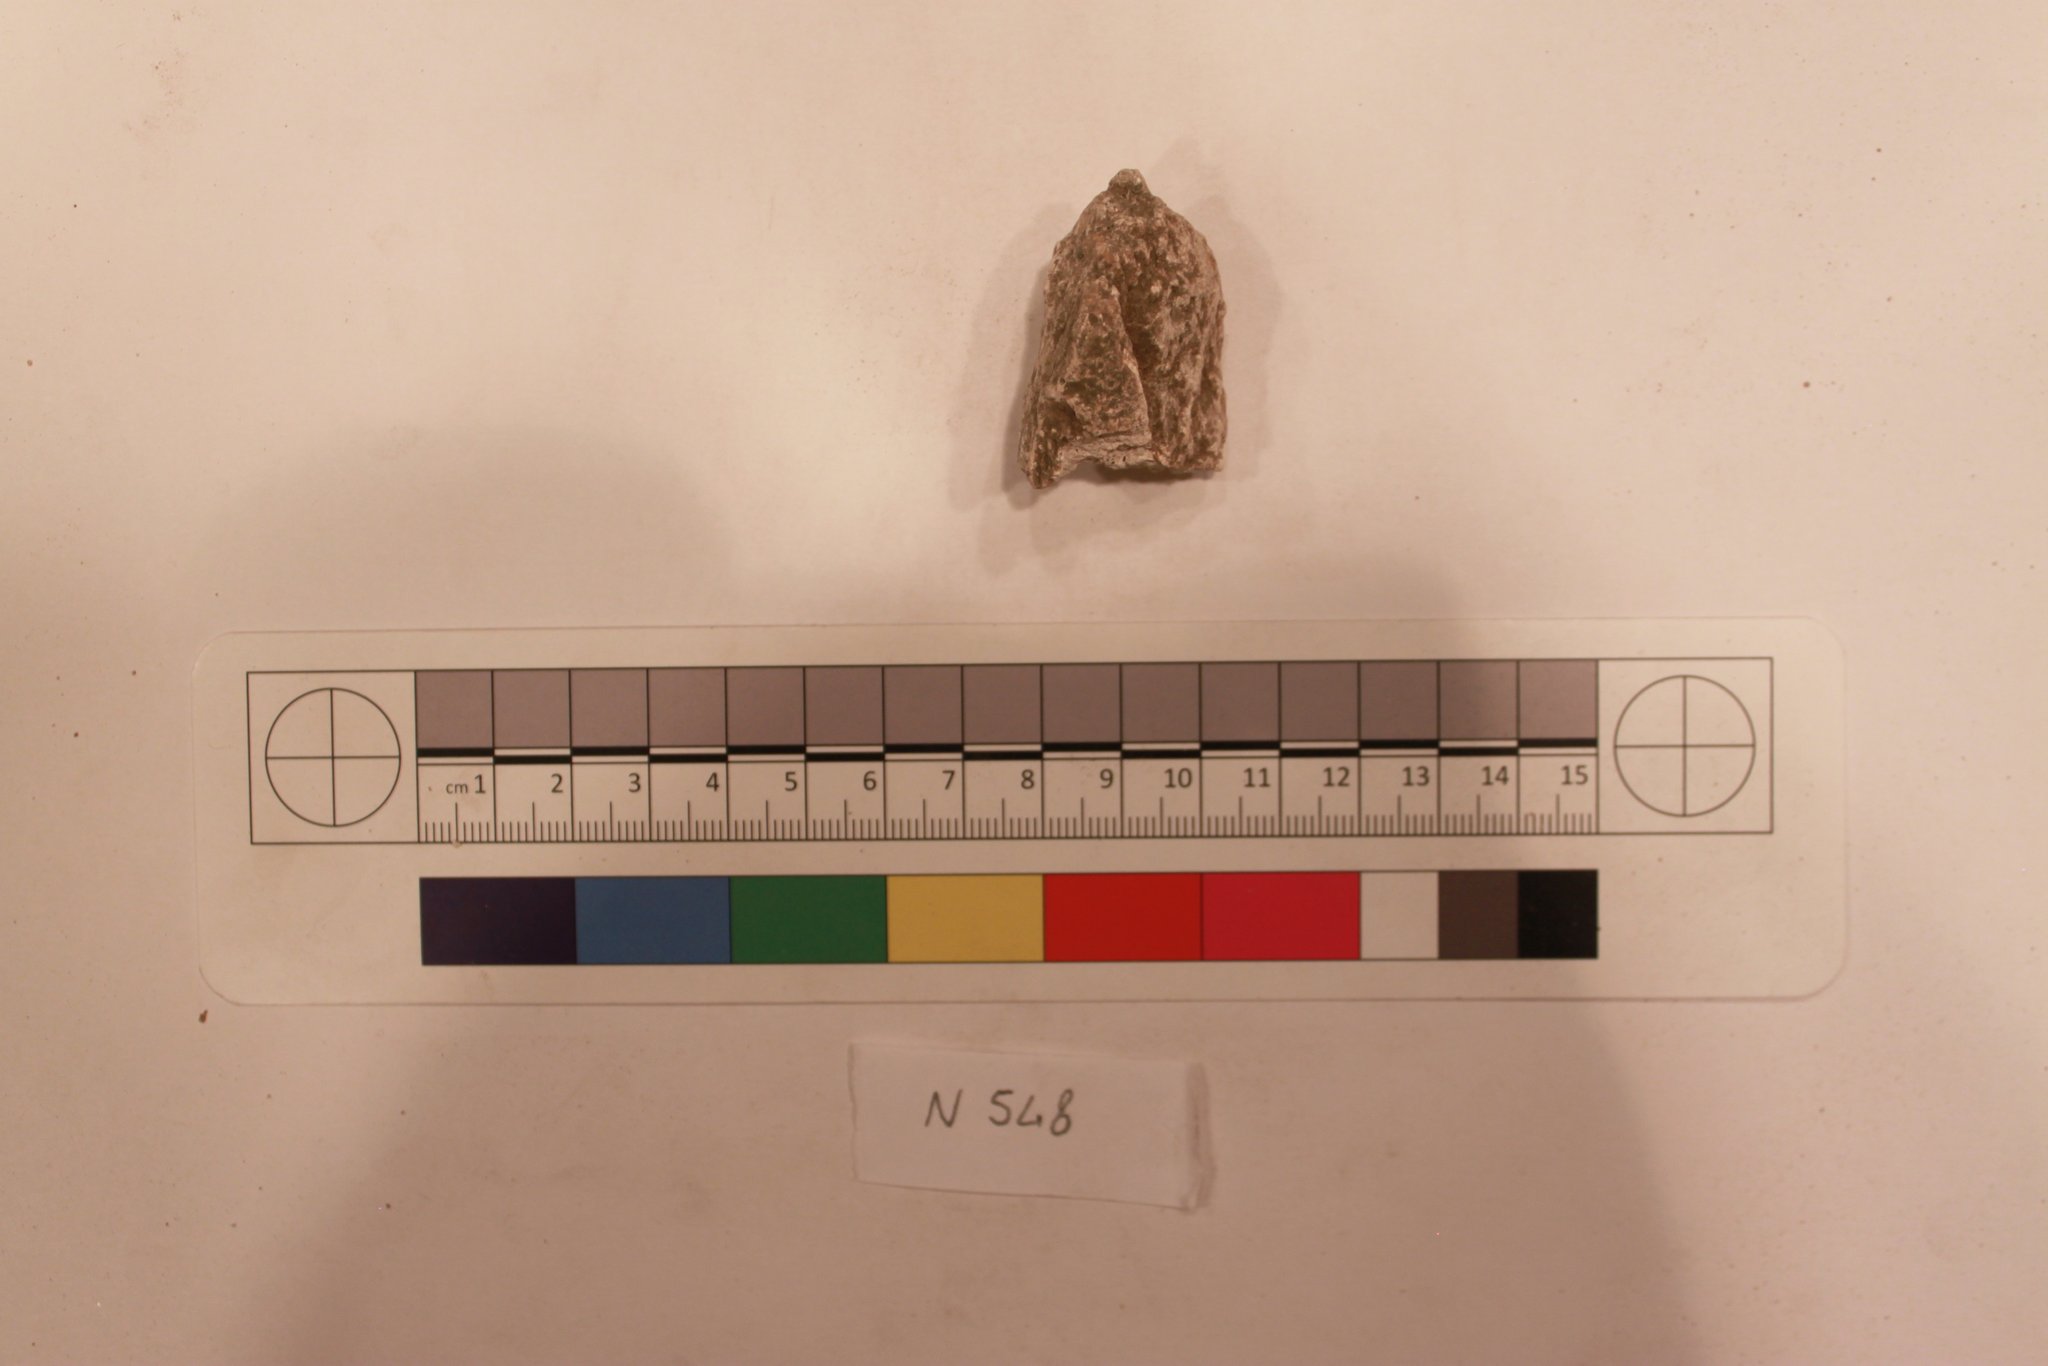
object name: fragment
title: Stucco Fragment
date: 701-1200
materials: plaster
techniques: carving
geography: iran